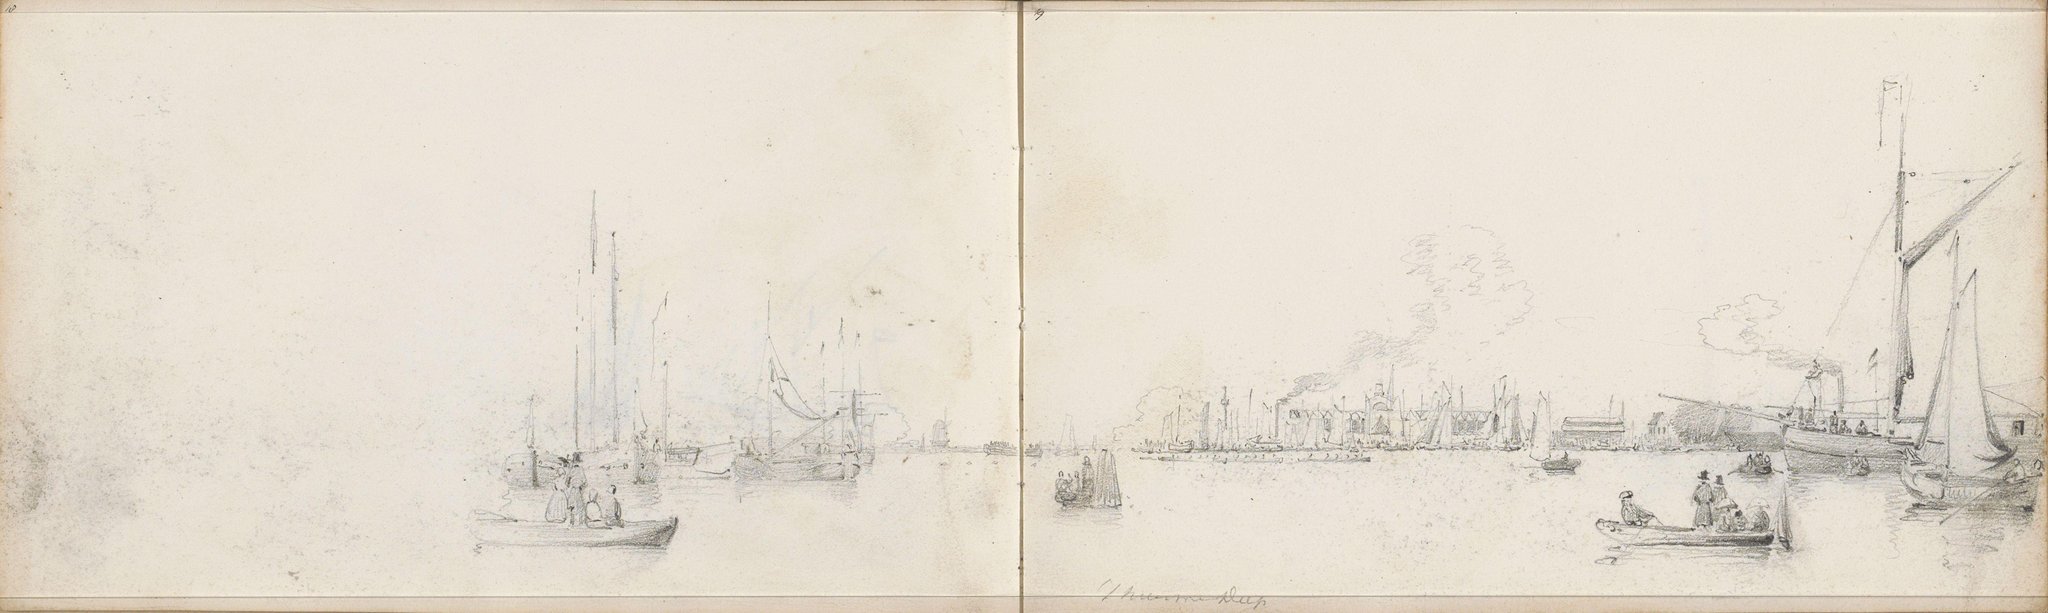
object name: sketchbook leaf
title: Gezicht op 't Nieuwe Diep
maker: petrus johannes schotel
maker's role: draughtsman, painter, print maker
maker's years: 1808-1865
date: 1841-1865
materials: paper, pencil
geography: amsterdam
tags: sailing-ship, sailing-boat, lake, amsterdam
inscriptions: annotation: ‘'t nieuwe Diep’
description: Pagina 18 en 19 uit een schetsboek met 80 pagina's.